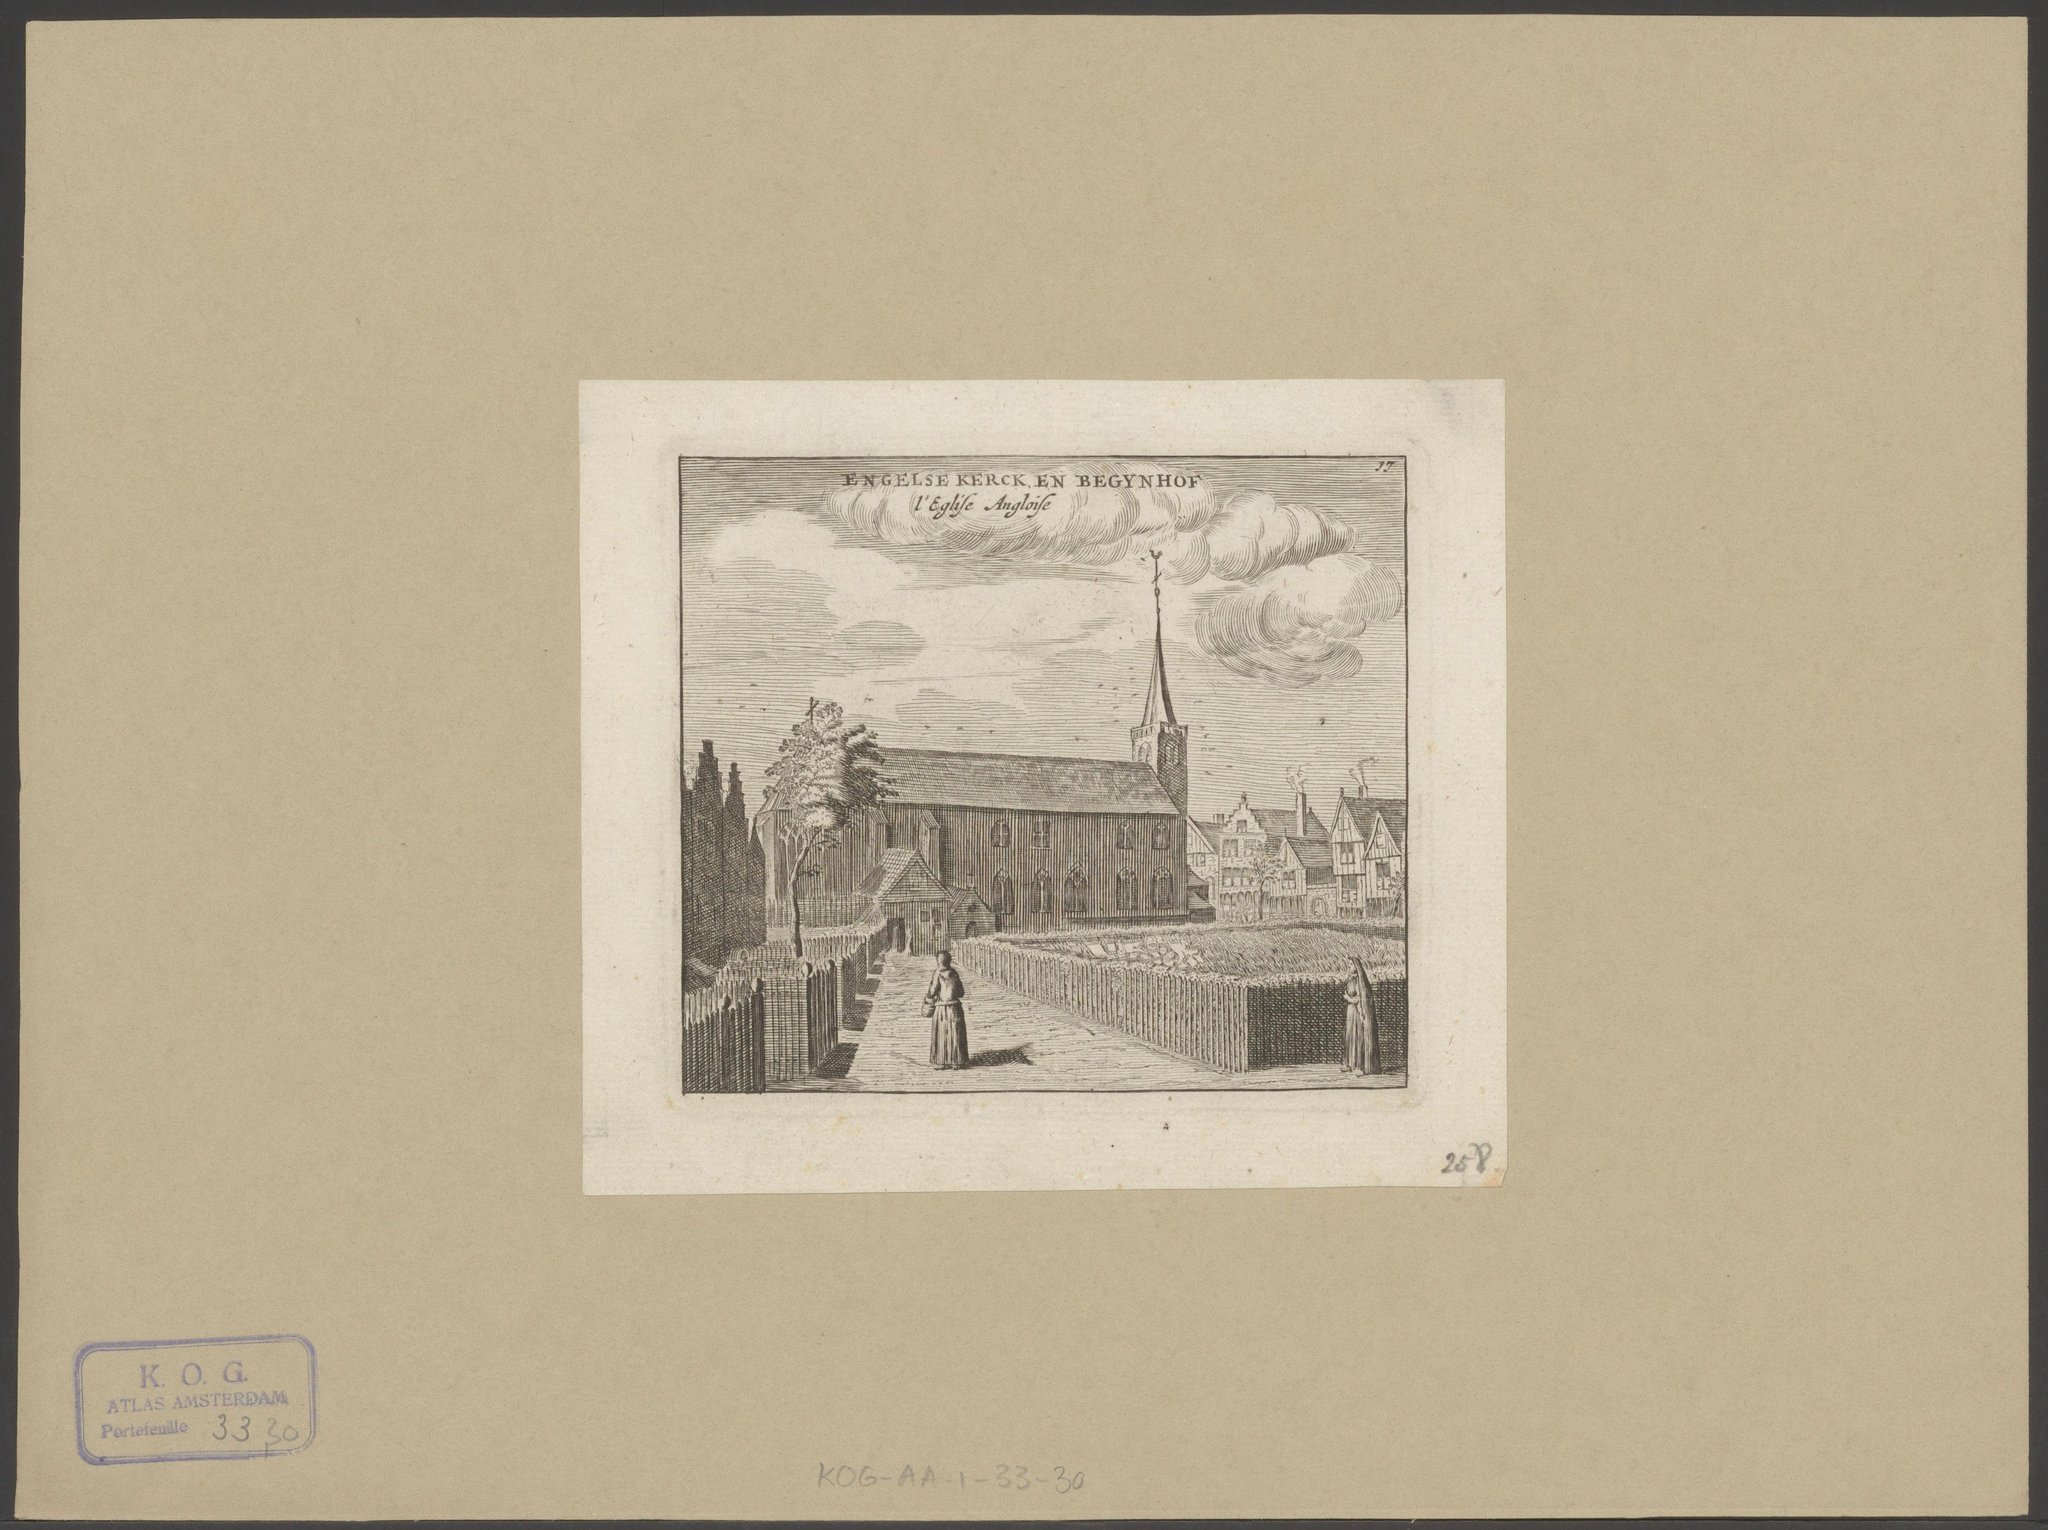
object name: print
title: Gezicht op de Engelse Kerk te Amsterdam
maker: jan veenhuysen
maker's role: print maker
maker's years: 1625-1693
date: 1681-1749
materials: paper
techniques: engraving, etching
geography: amsterdam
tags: church (exterior), street (+ city(-scape) with figures, staffage)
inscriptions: collector's mark: Lugt 1641b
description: Huidige staat van prent gebruikt in verschillende zeventiende- en achttiende-eeuwse publicaties. Eerste bekende staat ook gebruikt in: Fockens, Melchior. Beschrijvingh Der wijdt-vermaarde Koop-stadt Amstelredam (…). 3de druk. Amsterdam: Marcus Willemsz. Doornick, 1664. En in: Zesen, Philipp von. Beschreibung der Stadt Amsterdam (…). Amsterdam: Marcus Willemsz. Doornick, 1664. Tweede bekende staat ook gebruikt in: Domselaer, Tobias en Isaac Commelin. Beschryvinge van Amsterdam (…). 6 dln. Amsterdam: Marcus Willemsz. Doornick, 1665, dl. 4, p. 86.